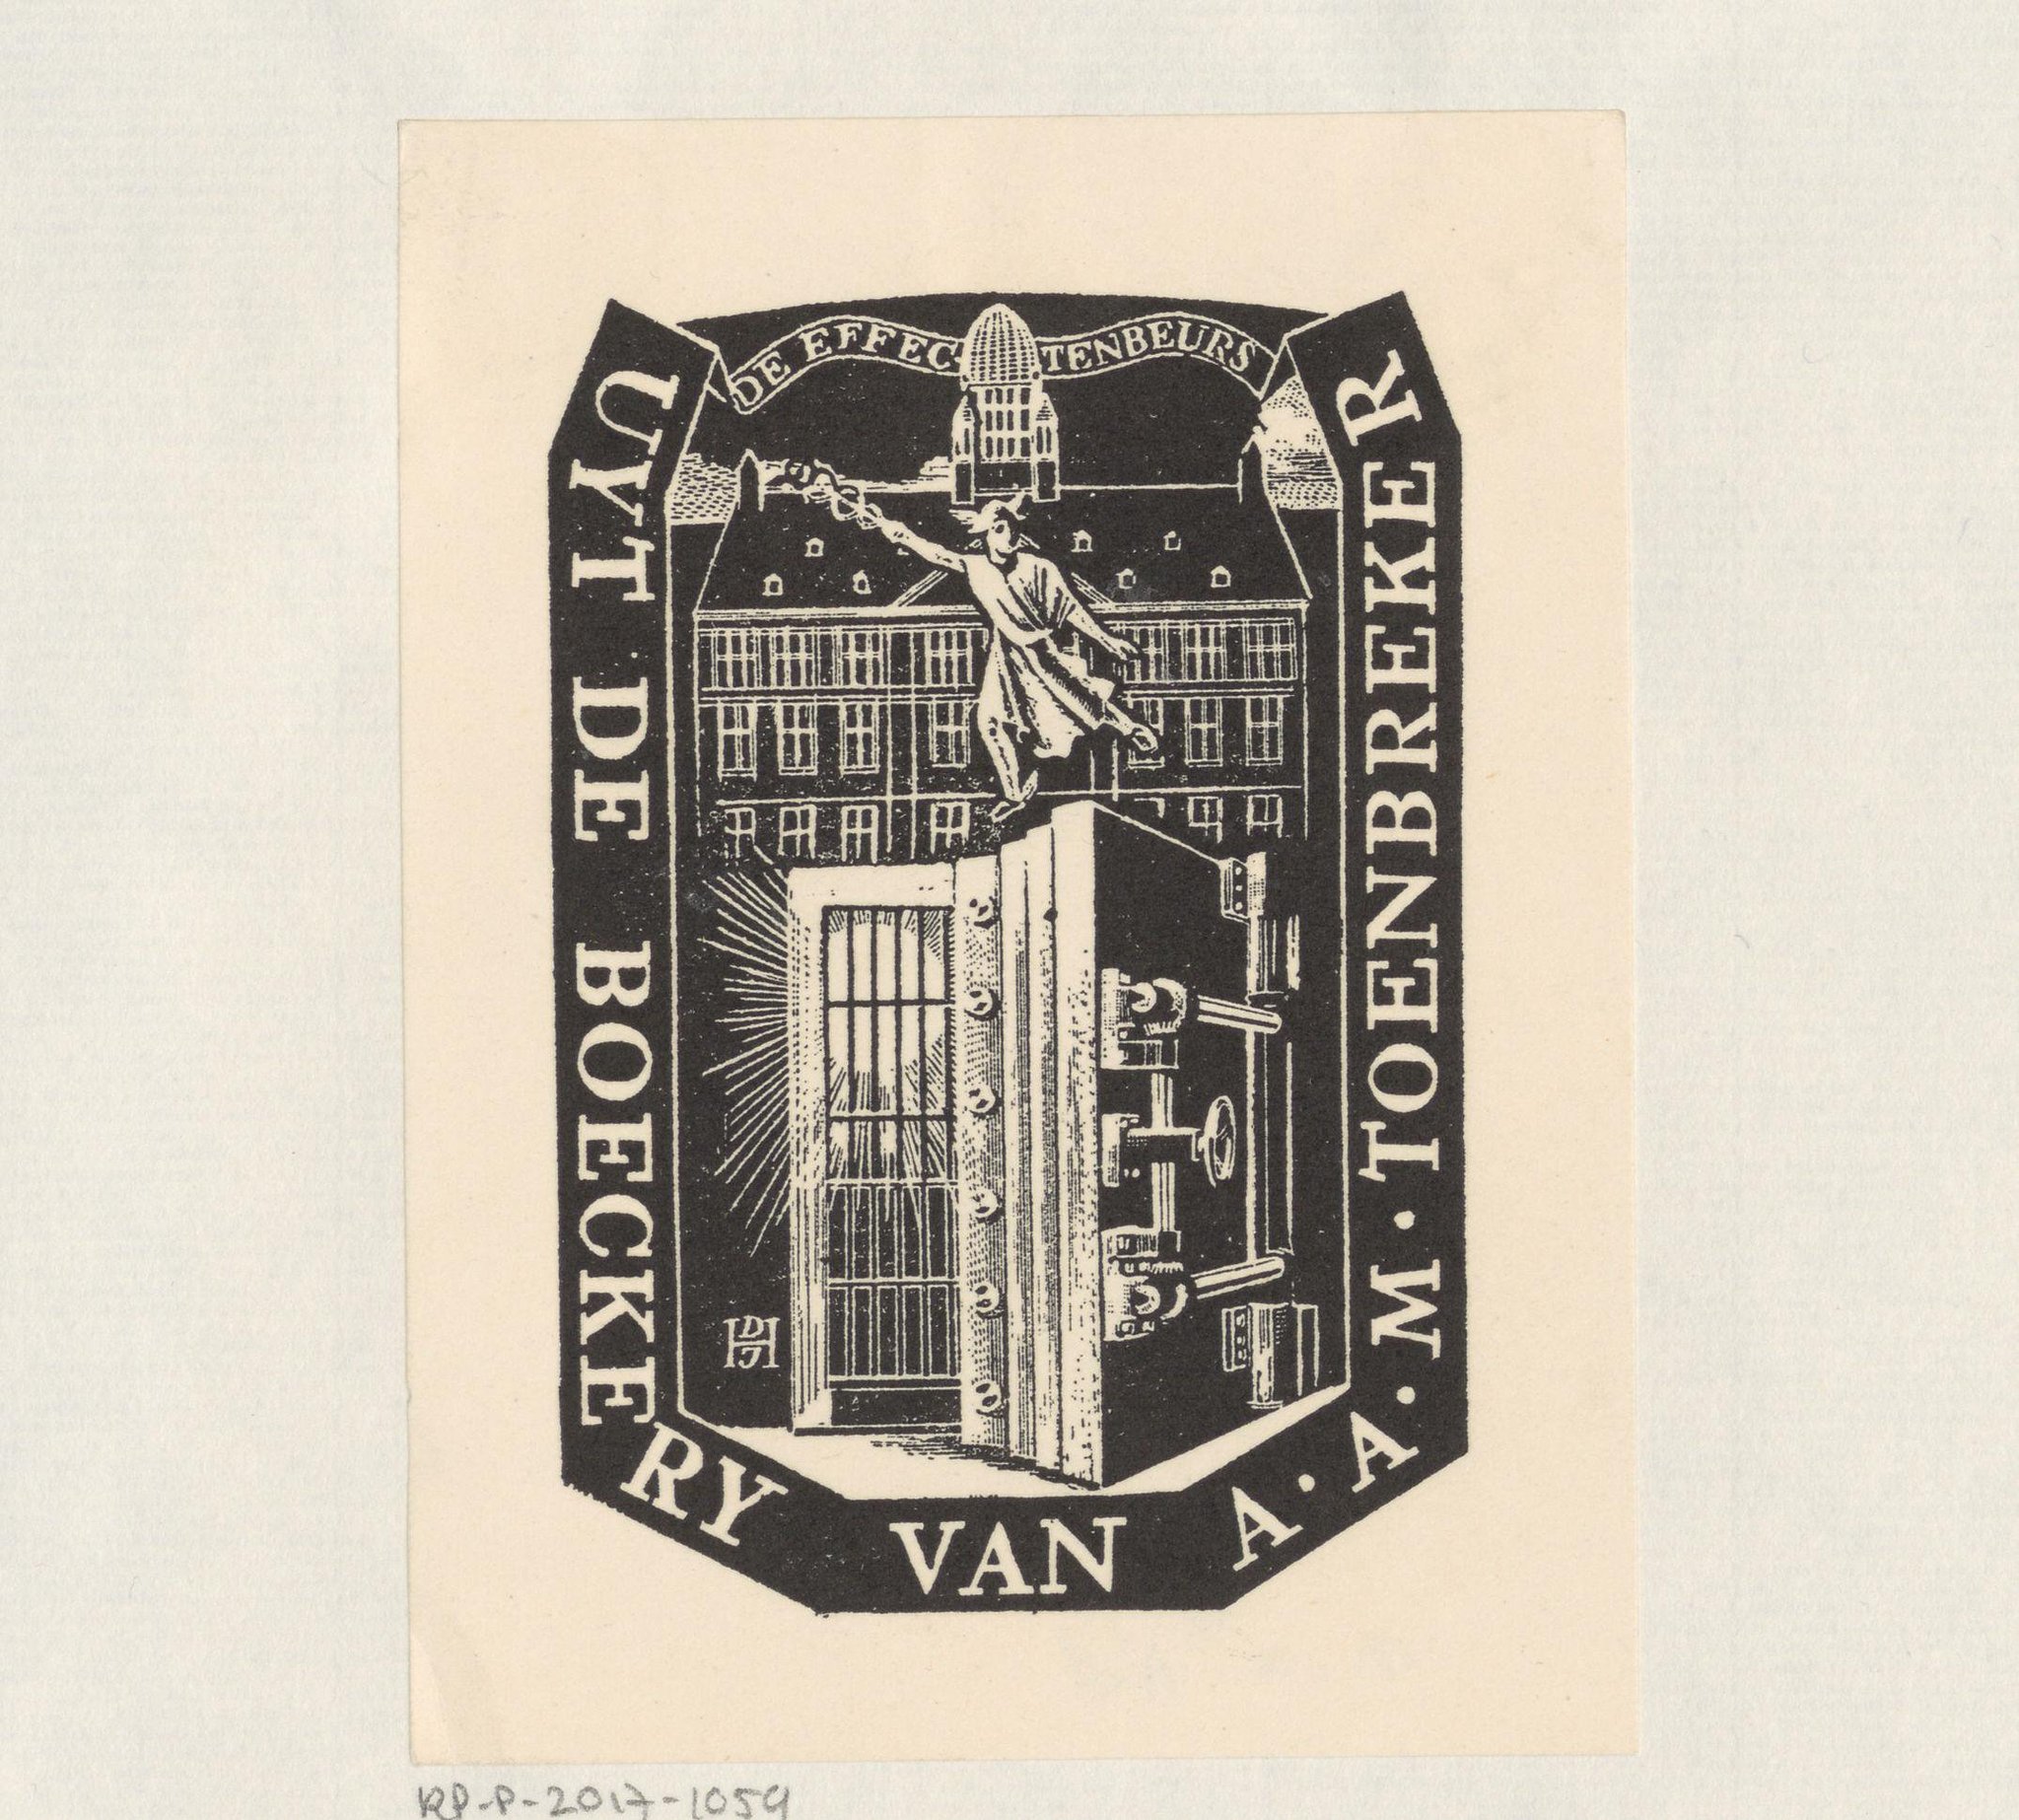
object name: bookplate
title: Ex libris van A.A.M. Toenbreker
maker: Anonymous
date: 1900-1999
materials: paper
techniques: printing block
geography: netherlands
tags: (story of) mercury (hermes), stock exchange, stock-market, trade, commerce and finance